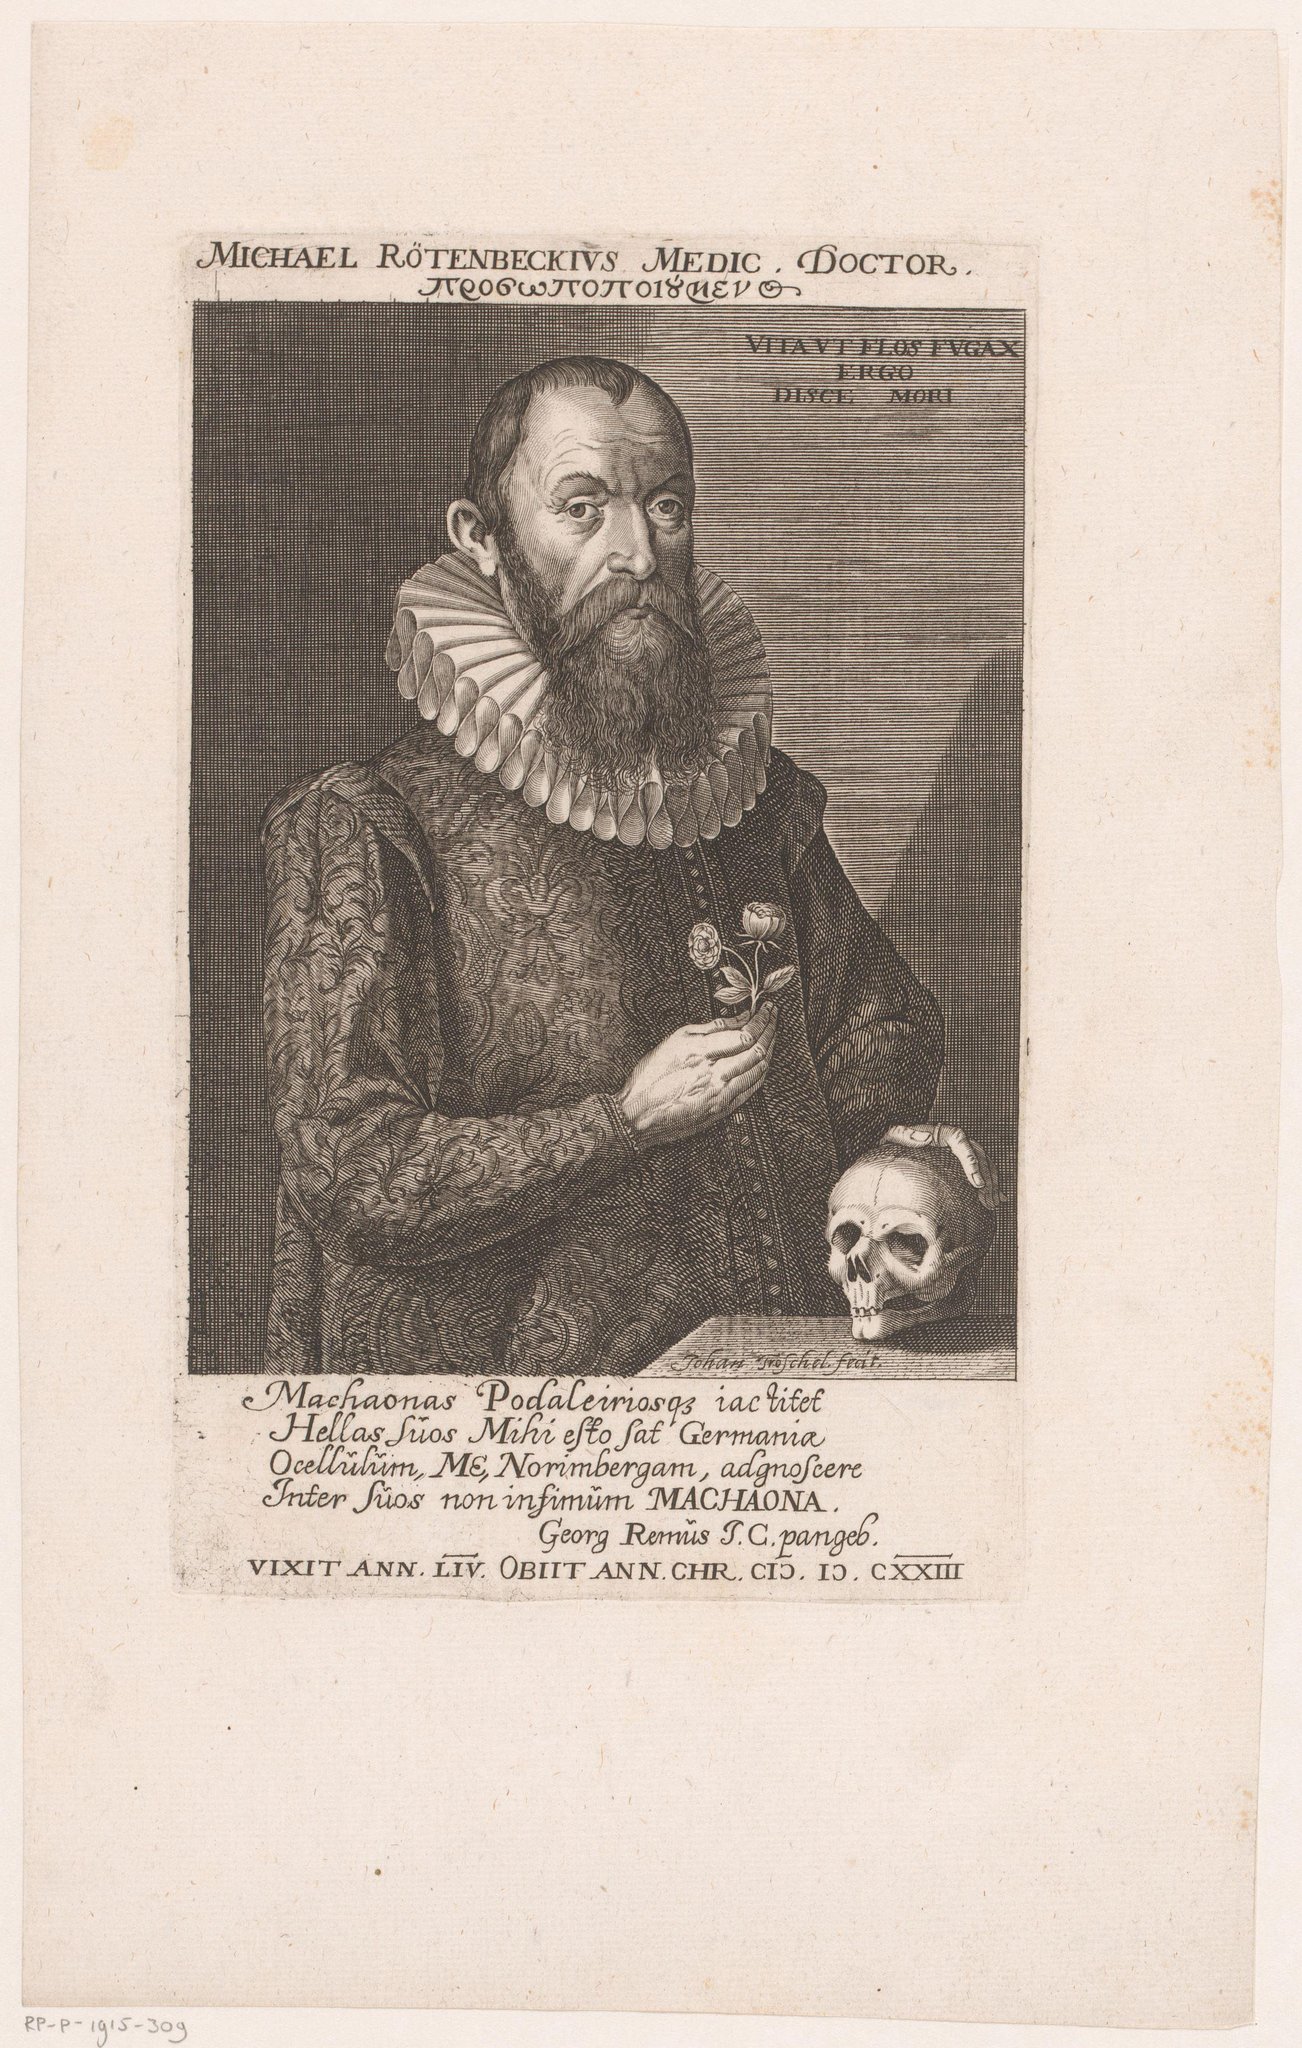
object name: print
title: Portret van Michael Rötenbeck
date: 1623-1628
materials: paper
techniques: engraving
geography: germany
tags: historical persons, skull as symbol of 'vanitas', flowers: rose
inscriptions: collector's mark: Lugt 2228